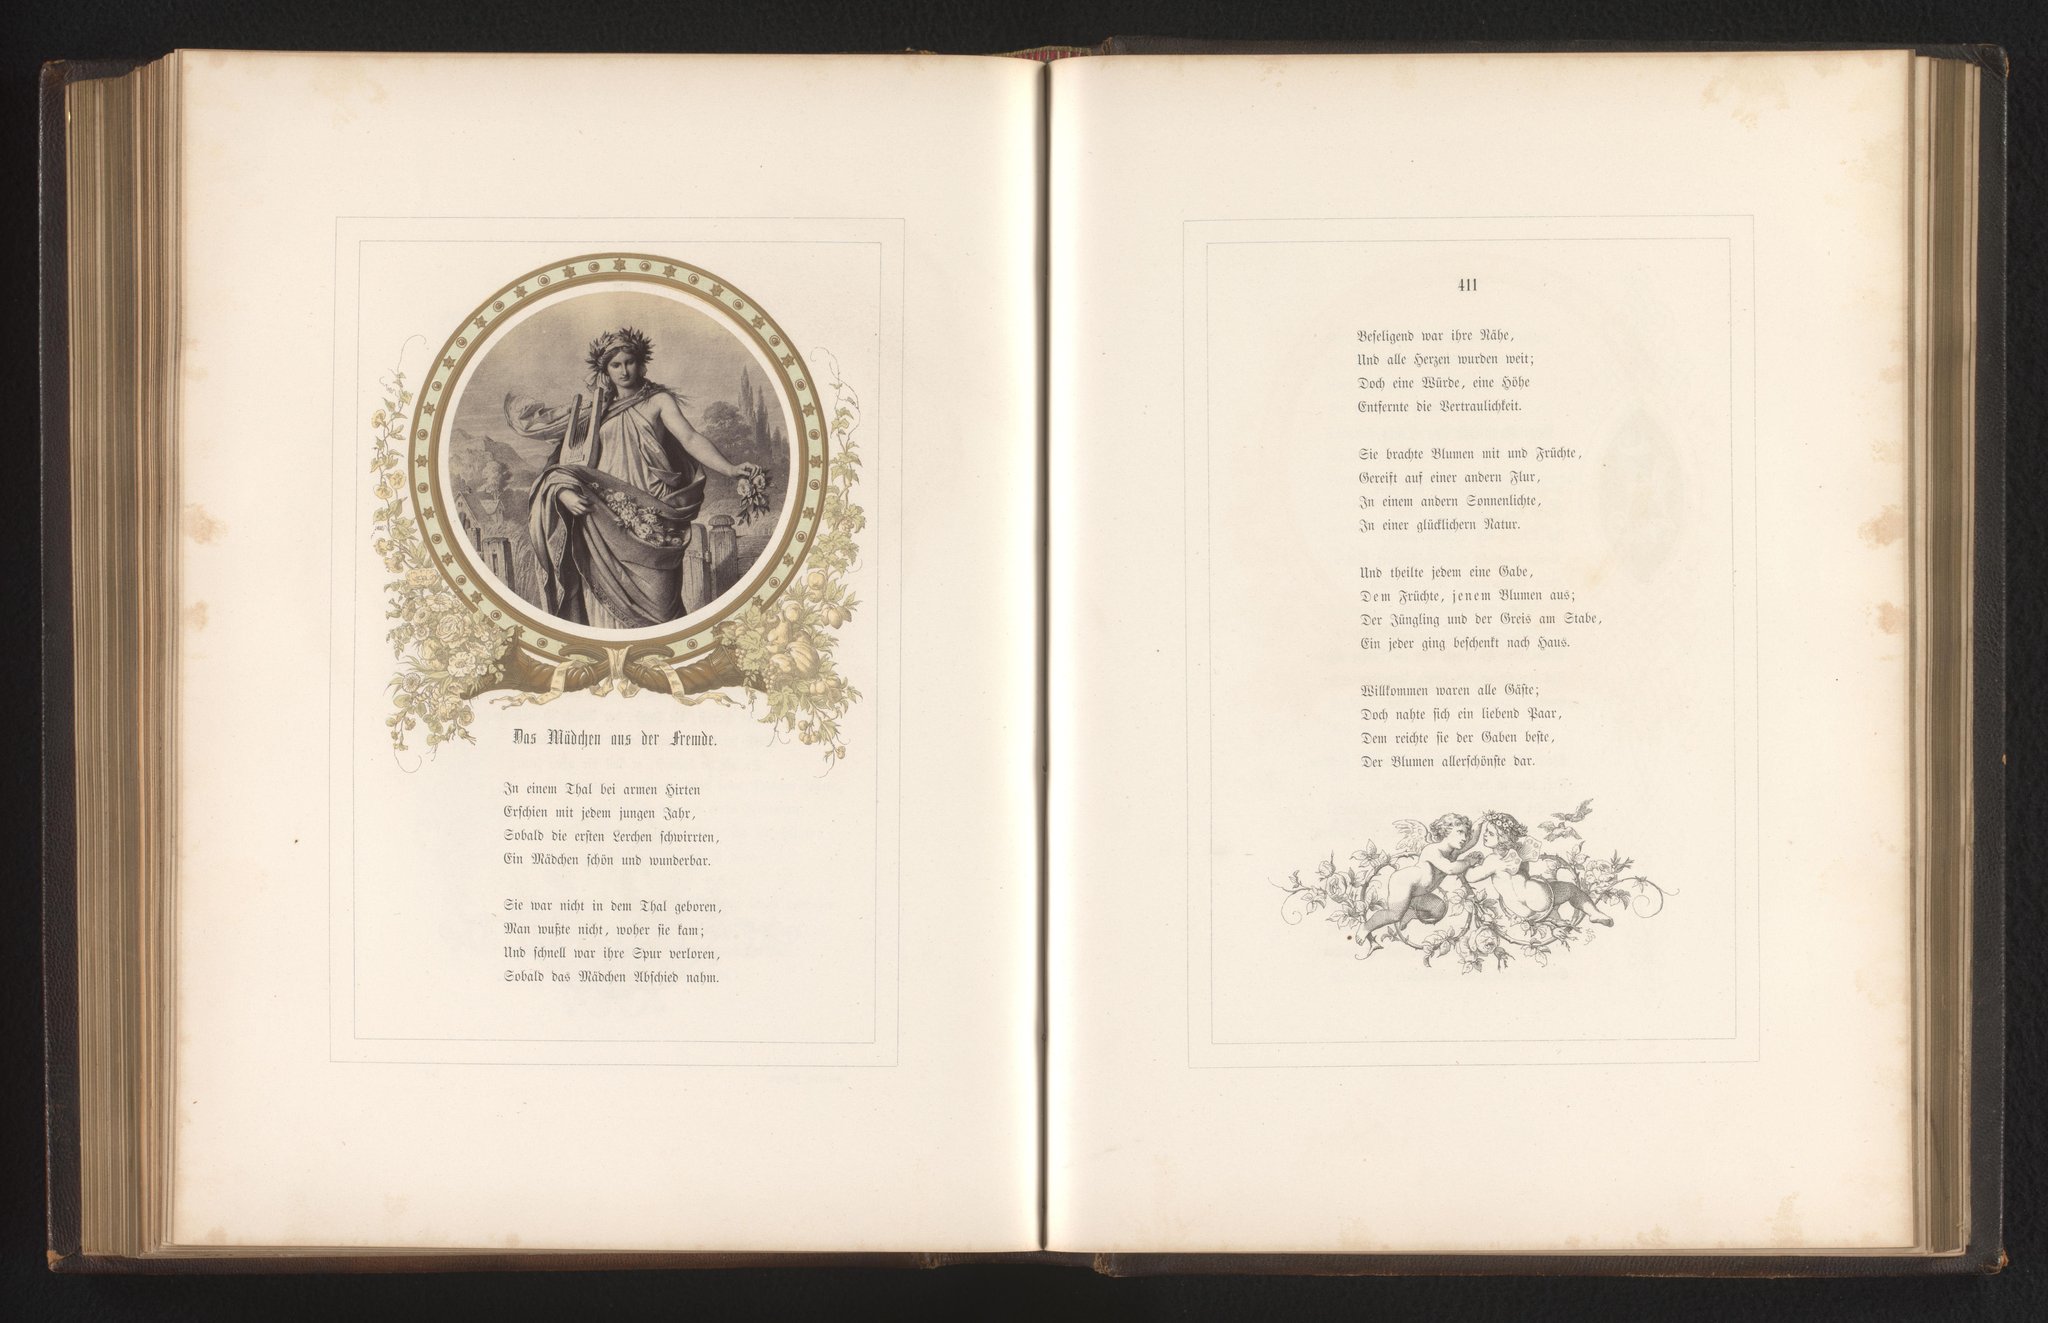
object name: page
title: Fotoreproductie van een tekening van een jonge vrouw met een lier door Arthur von Ramberg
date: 1855-1862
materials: paper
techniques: albumen print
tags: adolescent, young woman, maiden, lyre, cithara, psaltery